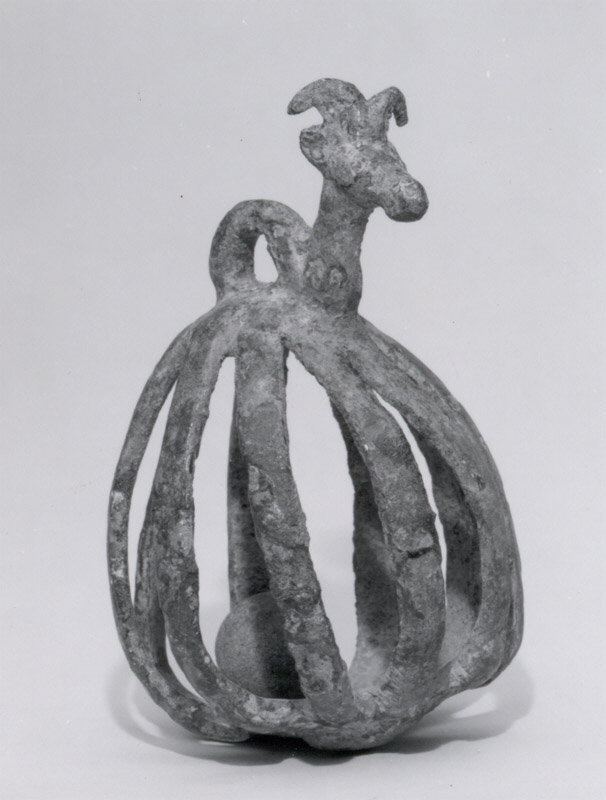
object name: rattle bell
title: Openwork rattle bell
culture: iranian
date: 900-701 BCE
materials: bronze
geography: western iran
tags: animals